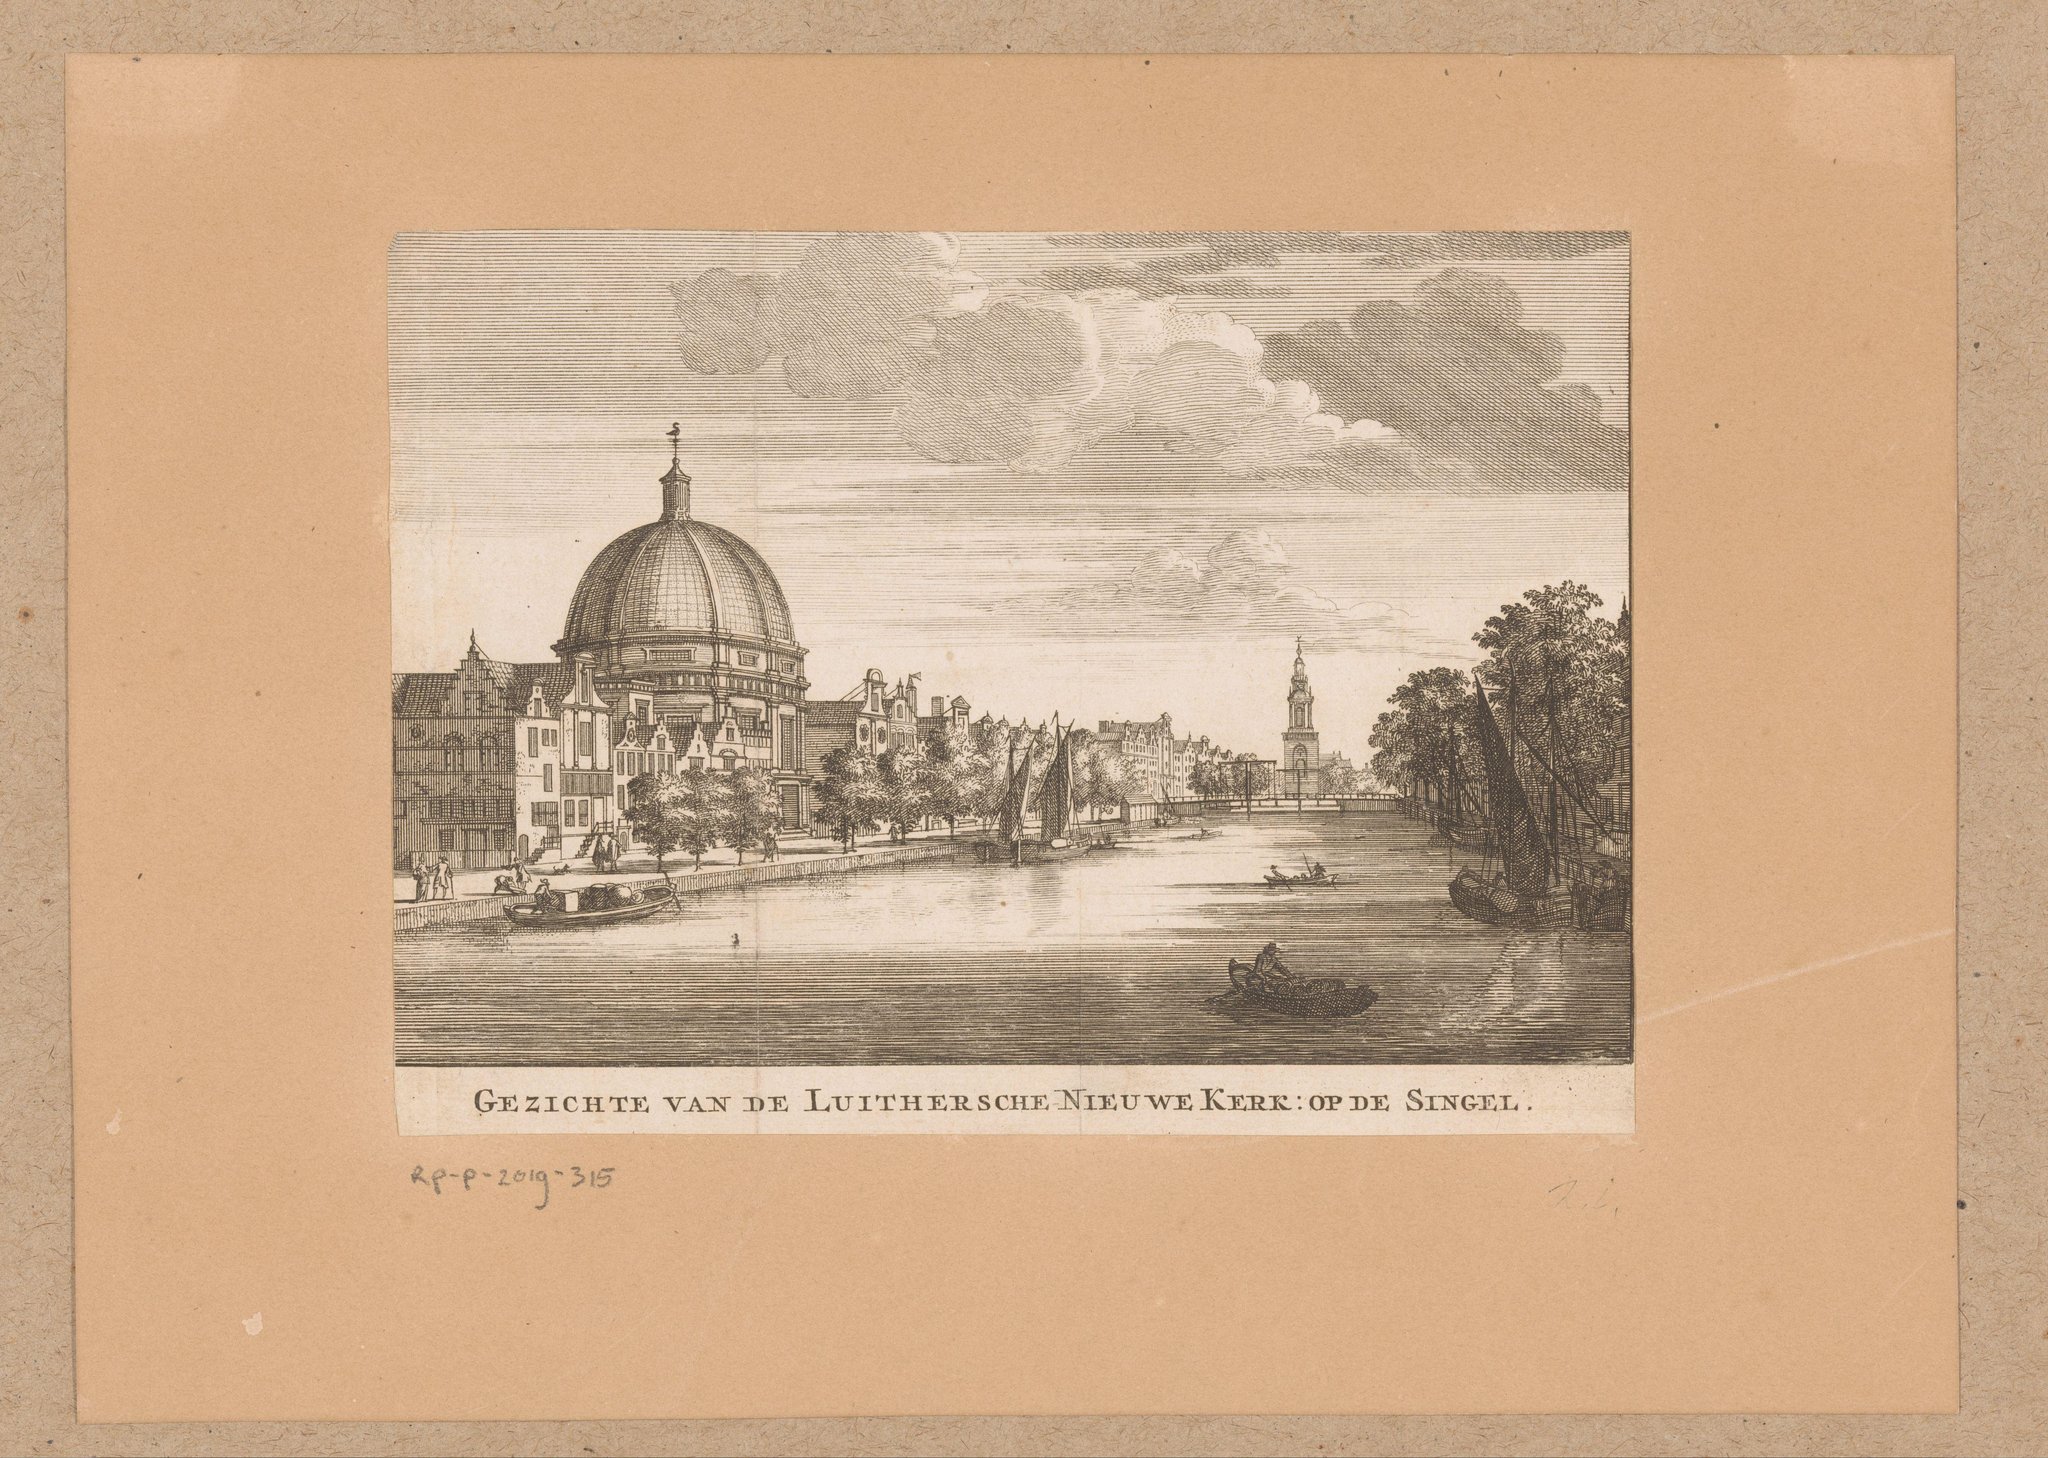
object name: print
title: Gezichte van de Luithersche Nieuwe Kerk: op de Singel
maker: Anonymous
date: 1713-1737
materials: paper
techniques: etching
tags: protestant churches and denominations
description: Prent verschenen in: Ratelband, Johannes. Wegwyzer of Korte beschryvinge van de stadt Amsterdam (...). Amsterdam: Erven van J. Ratelband en Co., 1737.